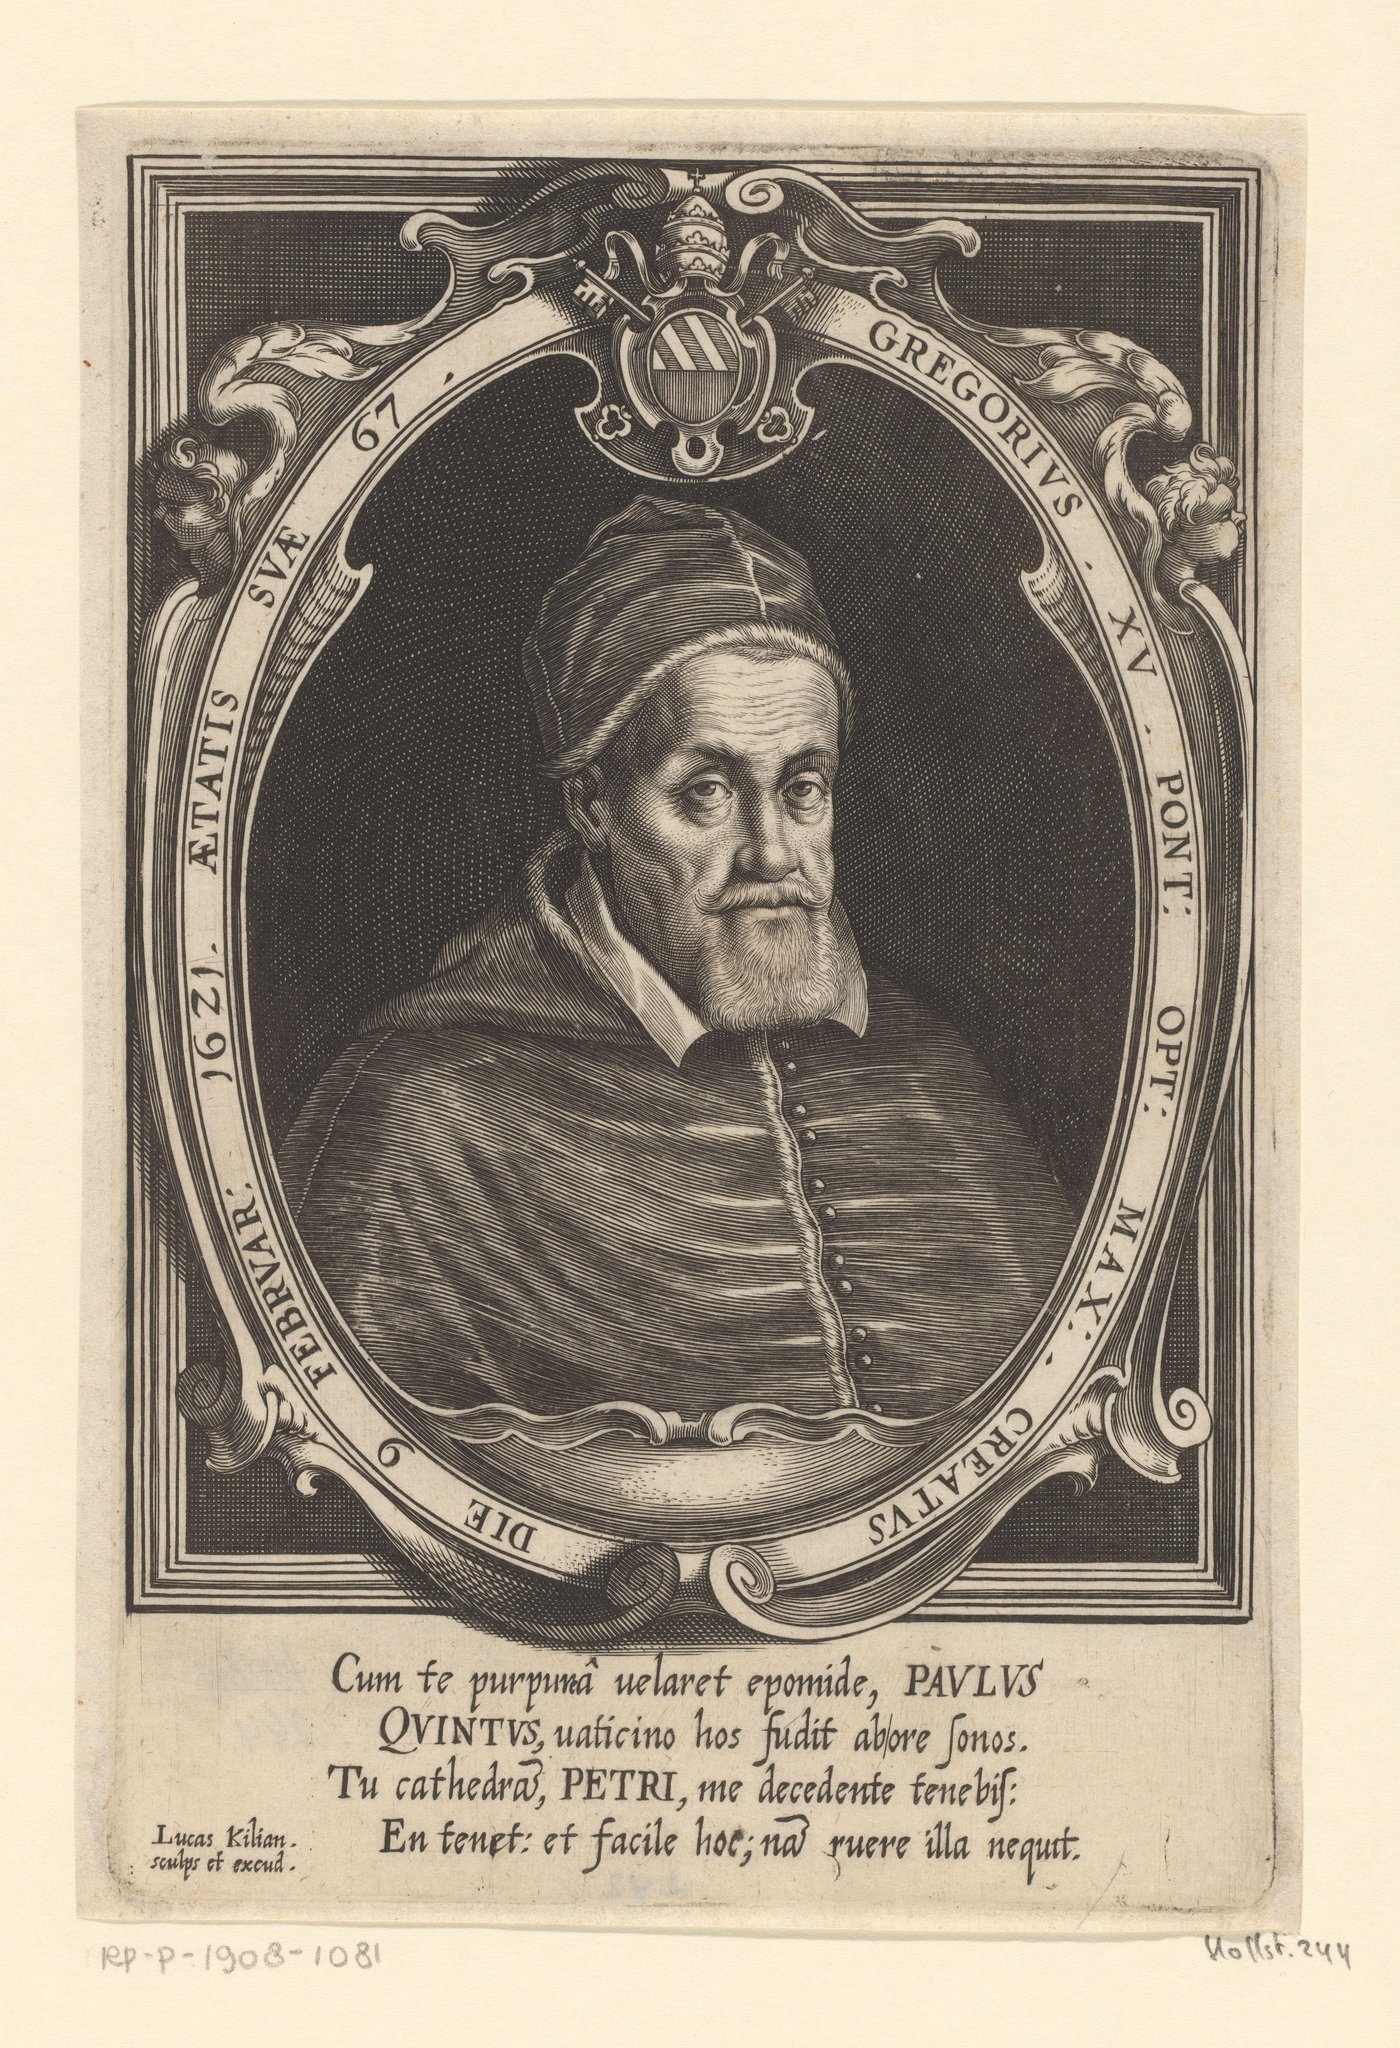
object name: print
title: Portret van paus Gregorius XV op 67-jarige leeftijd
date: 1621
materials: paper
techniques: engraving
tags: gregorius xv, historical persons, ruler, sovereign, pope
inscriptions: collector's mark: Lugt 2228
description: Tekst in het Latijn in de omlijsting en in de ondermarge.